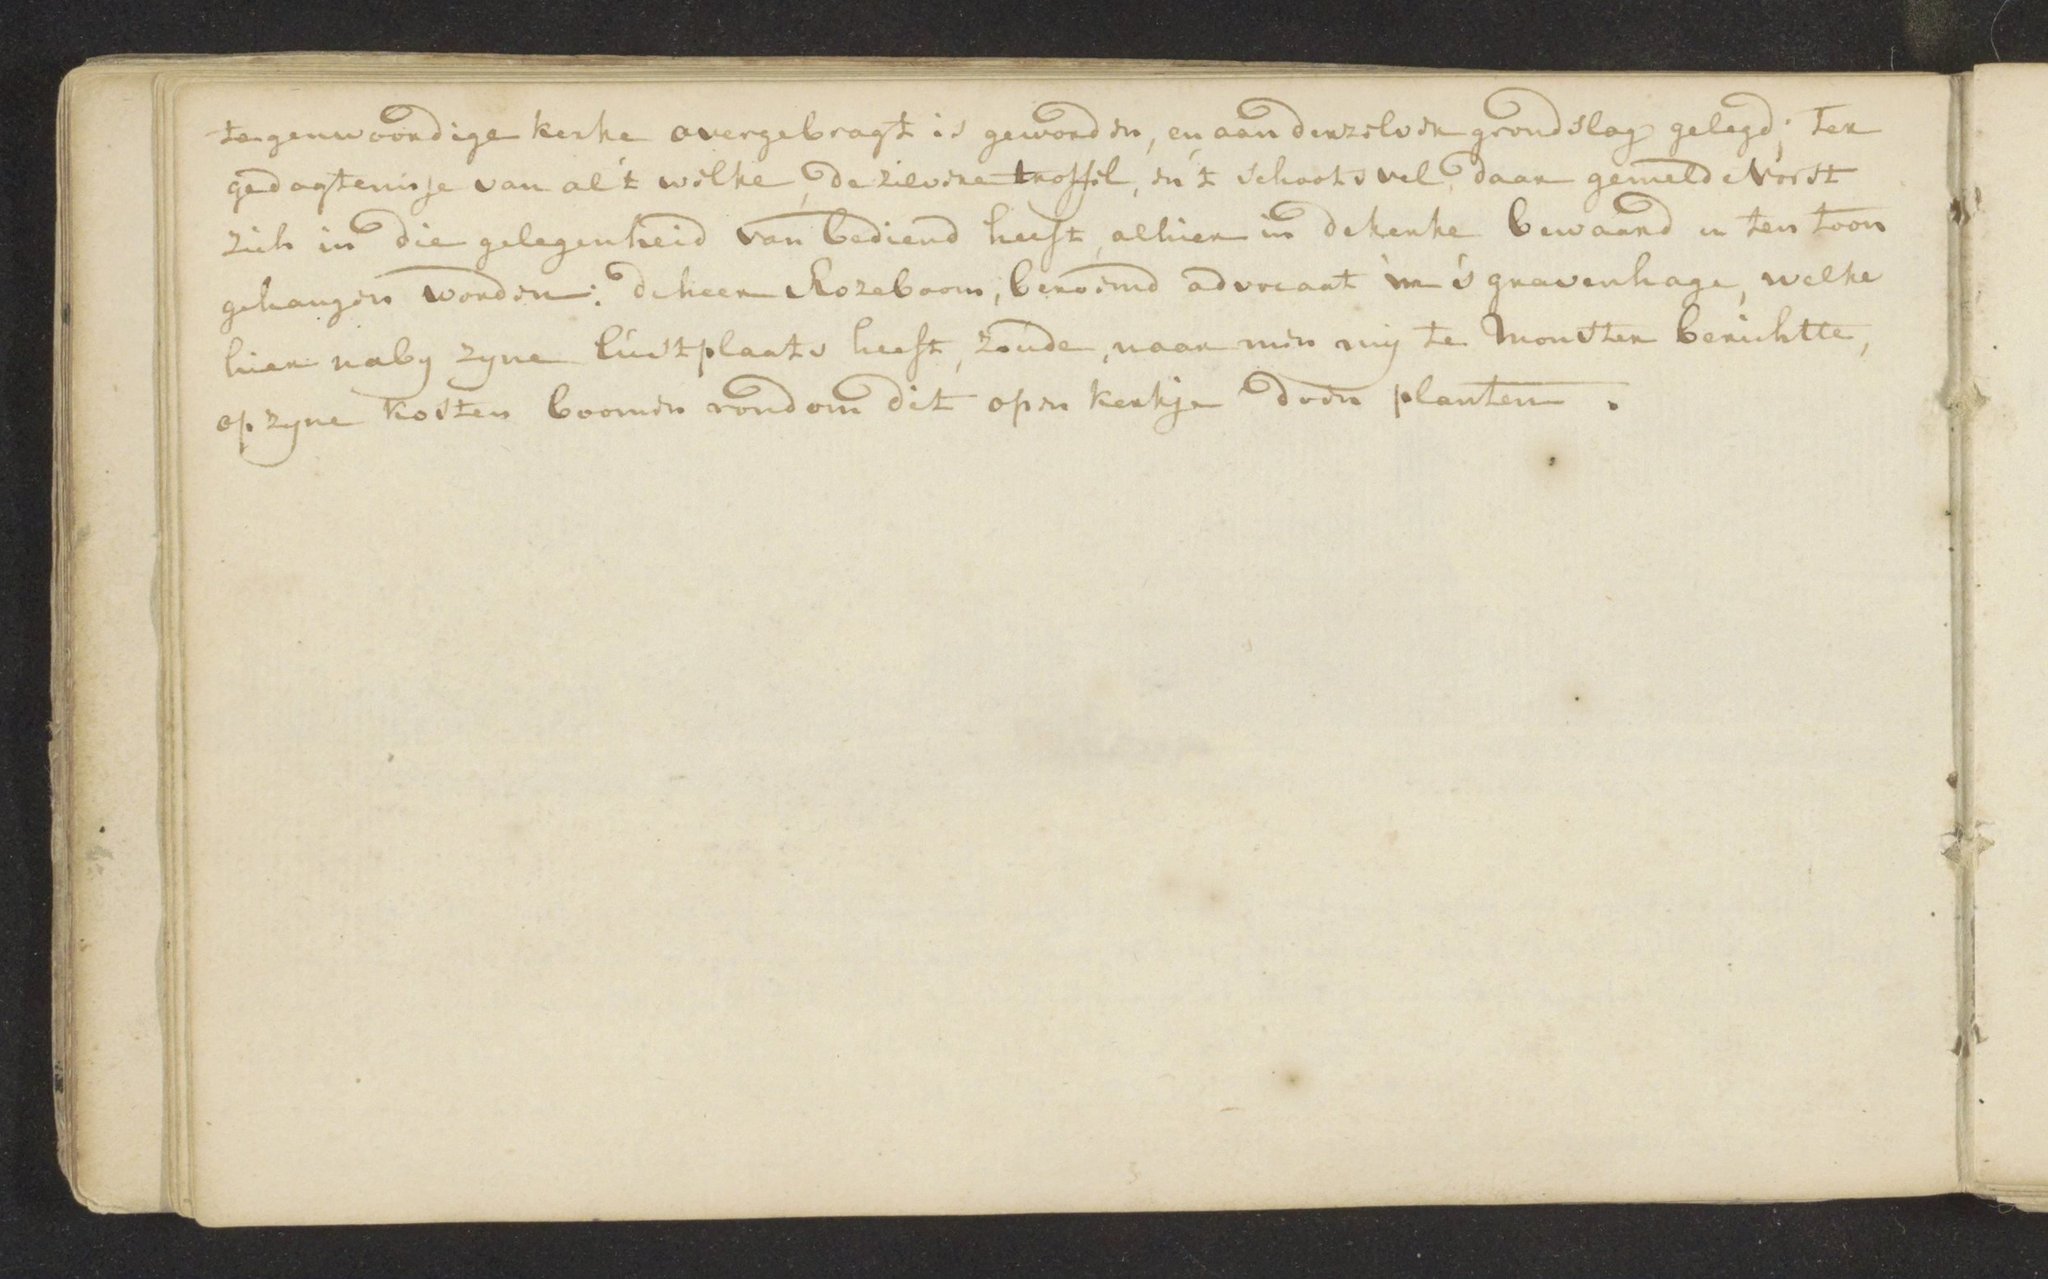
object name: sketchbook leaf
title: Annotatie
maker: abraham de haen (ii)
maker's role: draughtsman, print maker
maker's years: 1707-1748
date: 1731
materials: ink, paper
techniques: pen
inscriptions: annotation: ‘tegenwoordige kerke overgebracht ... kerkje do[...] planten’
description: Blad 13 verso uit een schetsboek met 78 bladen.